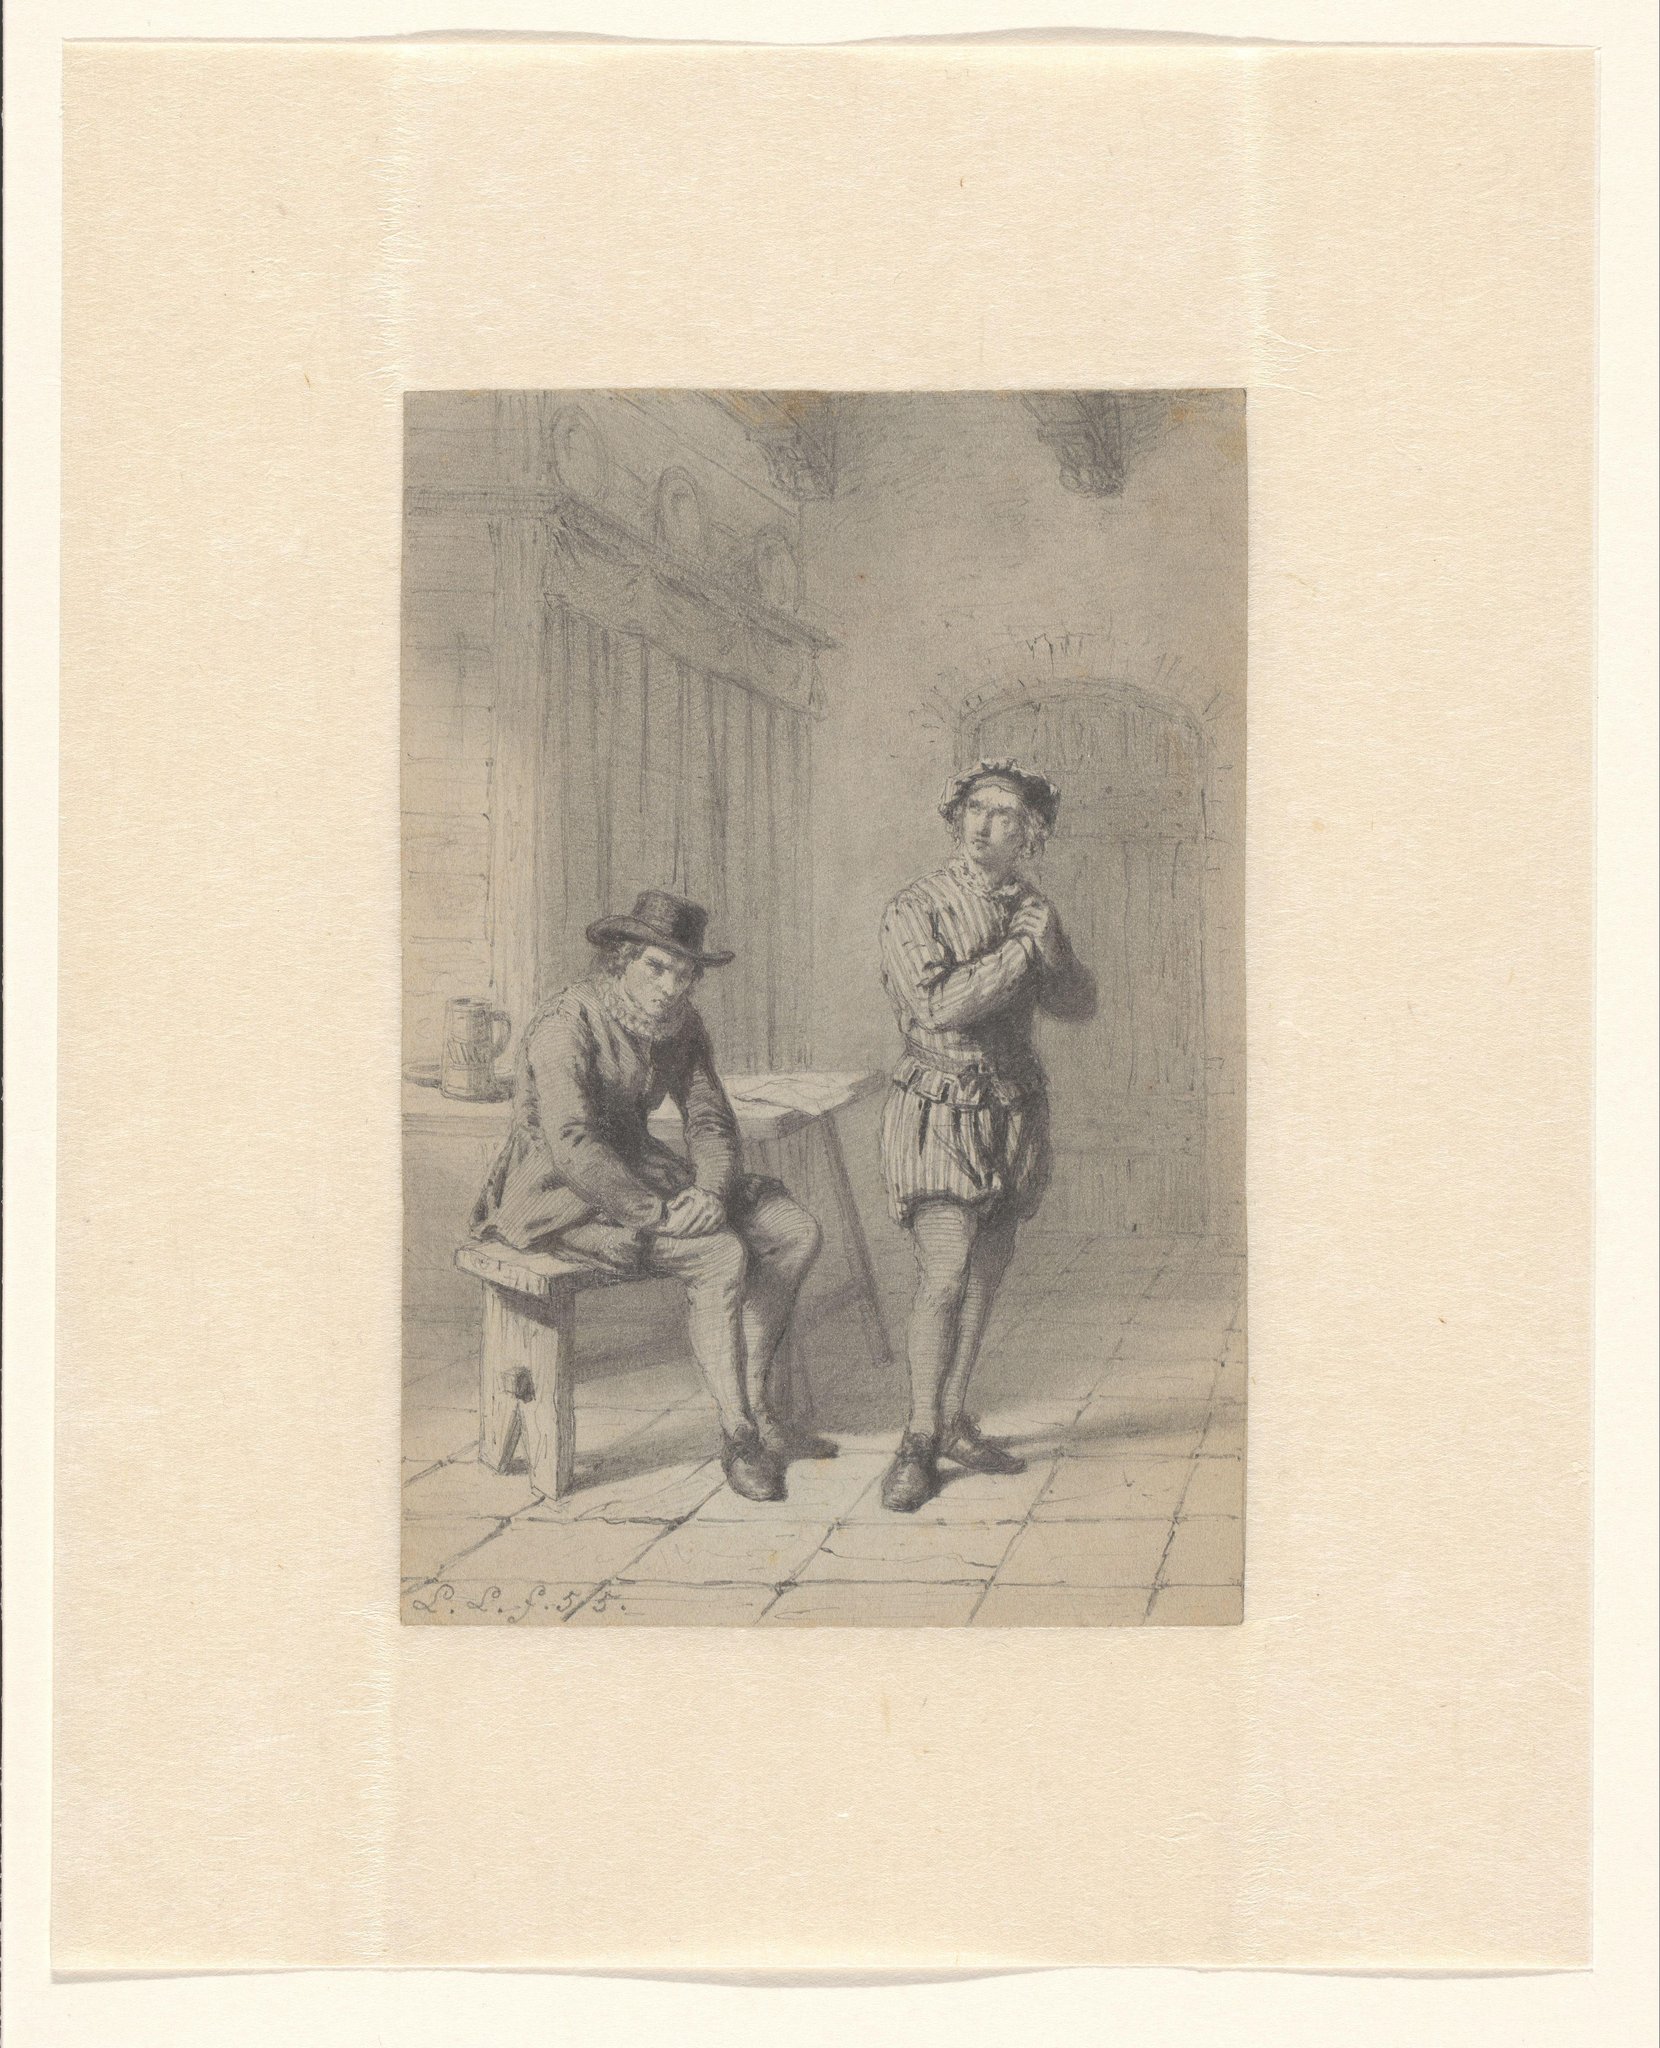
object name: drawing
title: Interieur met twee peinzende mannen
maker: lambertus lingeman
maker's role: draughtsman, painter, print maker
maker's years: 1829-1894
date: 1855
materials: paper, pencil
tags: communal rooms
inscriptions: collector's mark: Lugt 2228a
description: De ene man zit op een bank bij een tafel. De andere man heeft de handen ineengeslagen en werpt zijn blik omhoog.